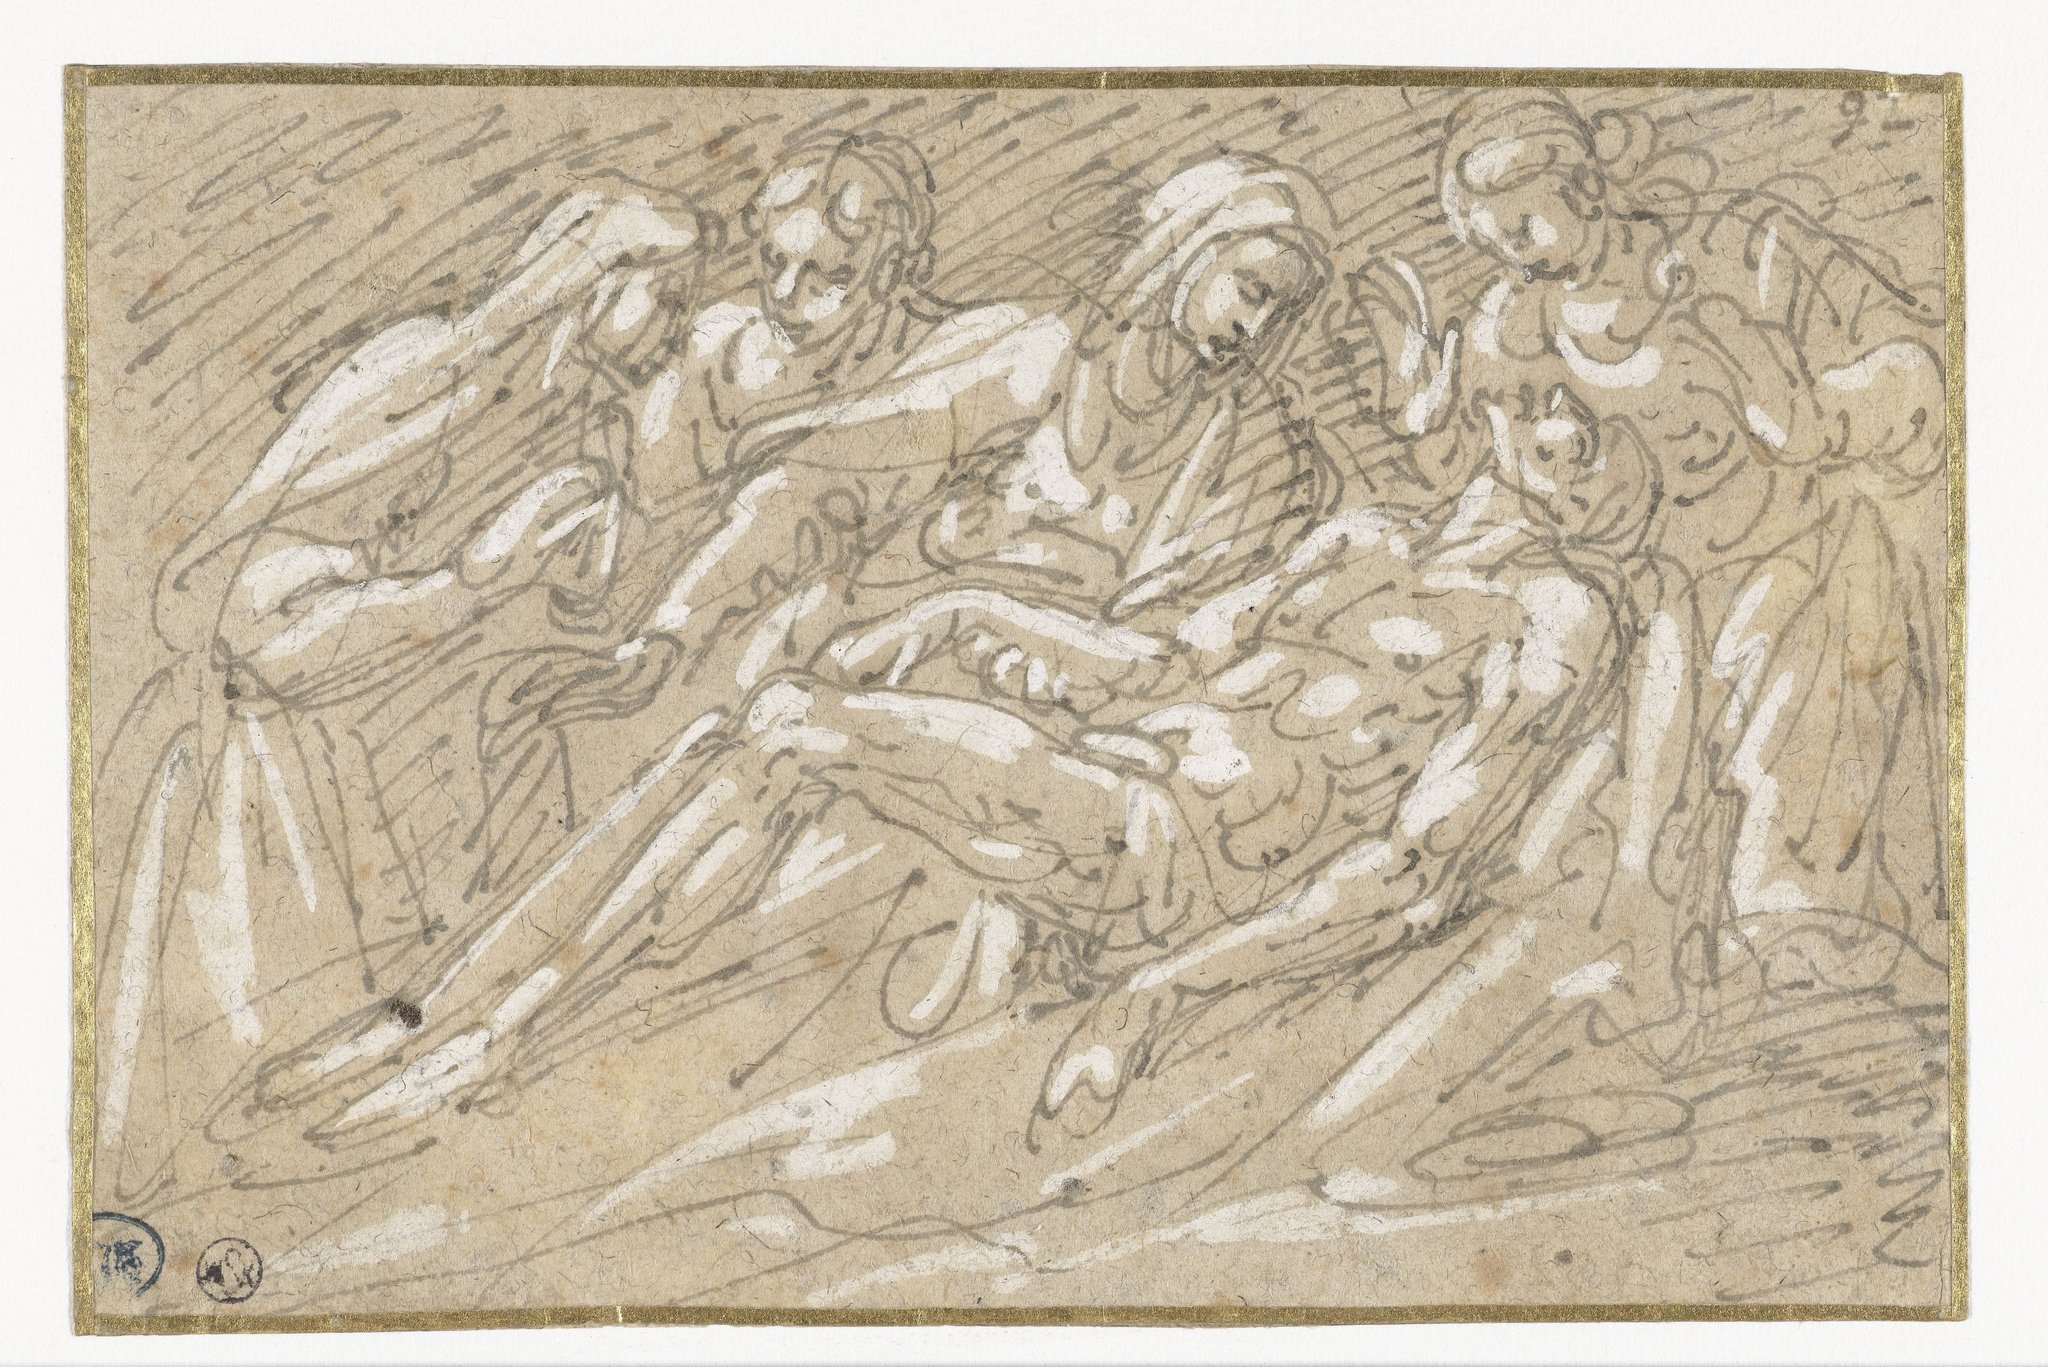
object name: drawing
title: Studie voor een bewening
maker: pseudo-gherardi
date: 1600-1699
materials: ink, paint, paper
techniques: pen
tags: lamentation over the dead christ by his relatives and friends (christ usually without crown of thorns)